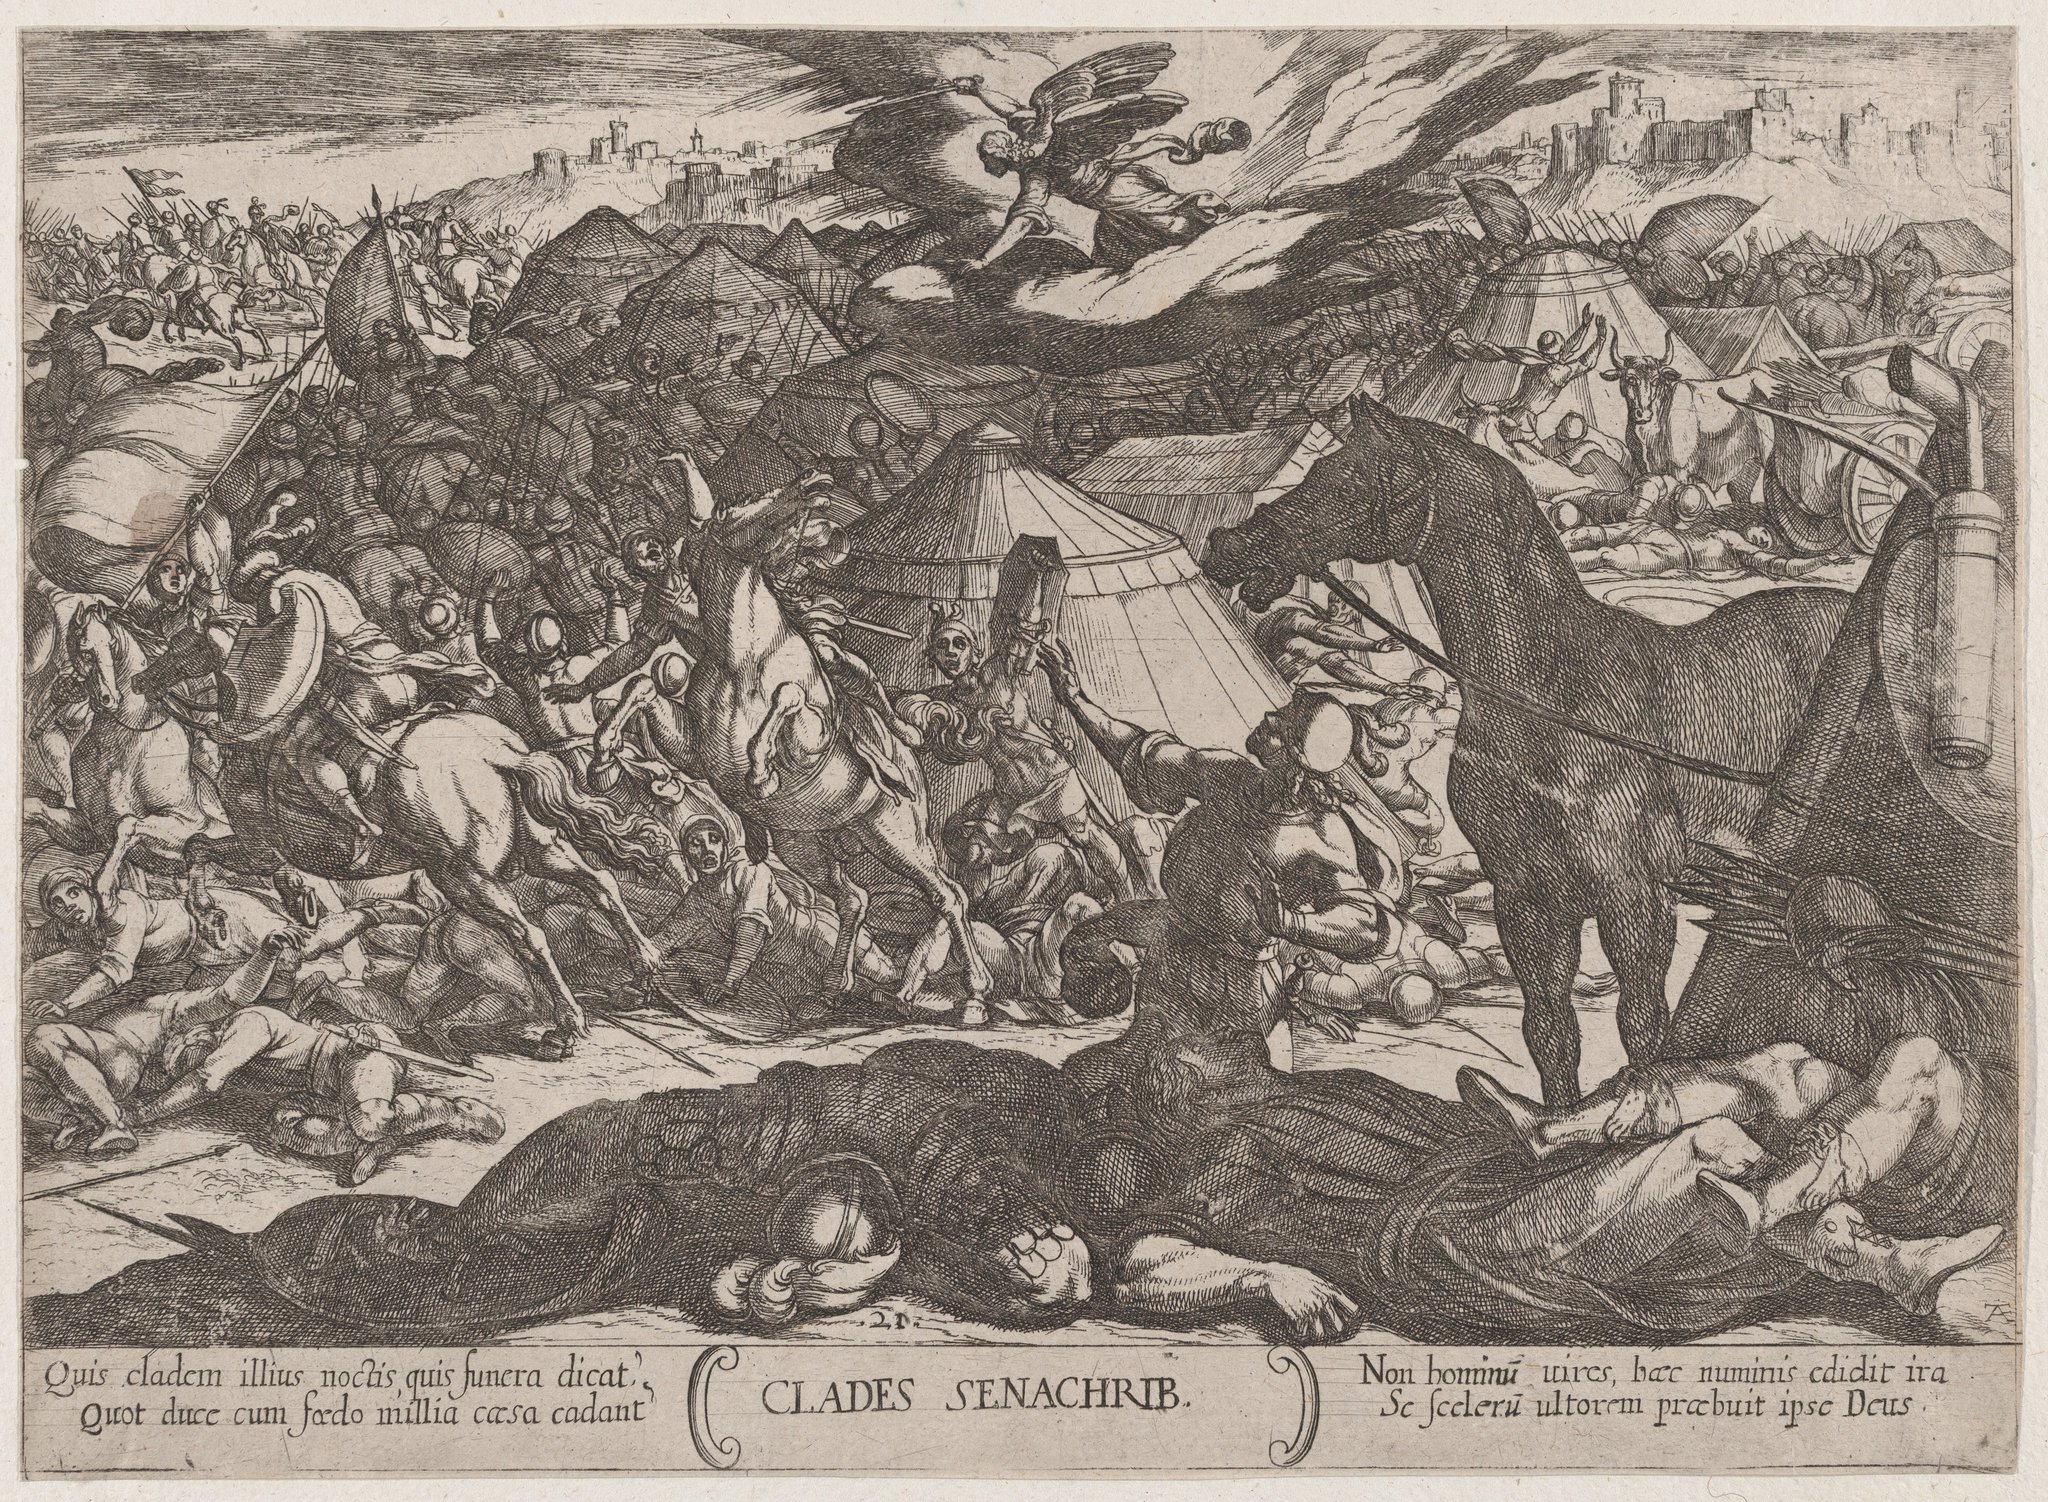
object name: print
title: Plate 21: The Angel of the Lord Vanquishing the Army of Sennacherib, from "The Battles of the Old Testament"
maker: antonio tempesta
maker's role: artist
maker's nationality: italian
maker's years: 1555-1630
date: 1590-1610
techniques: etching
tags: tents,battles,horses,angels